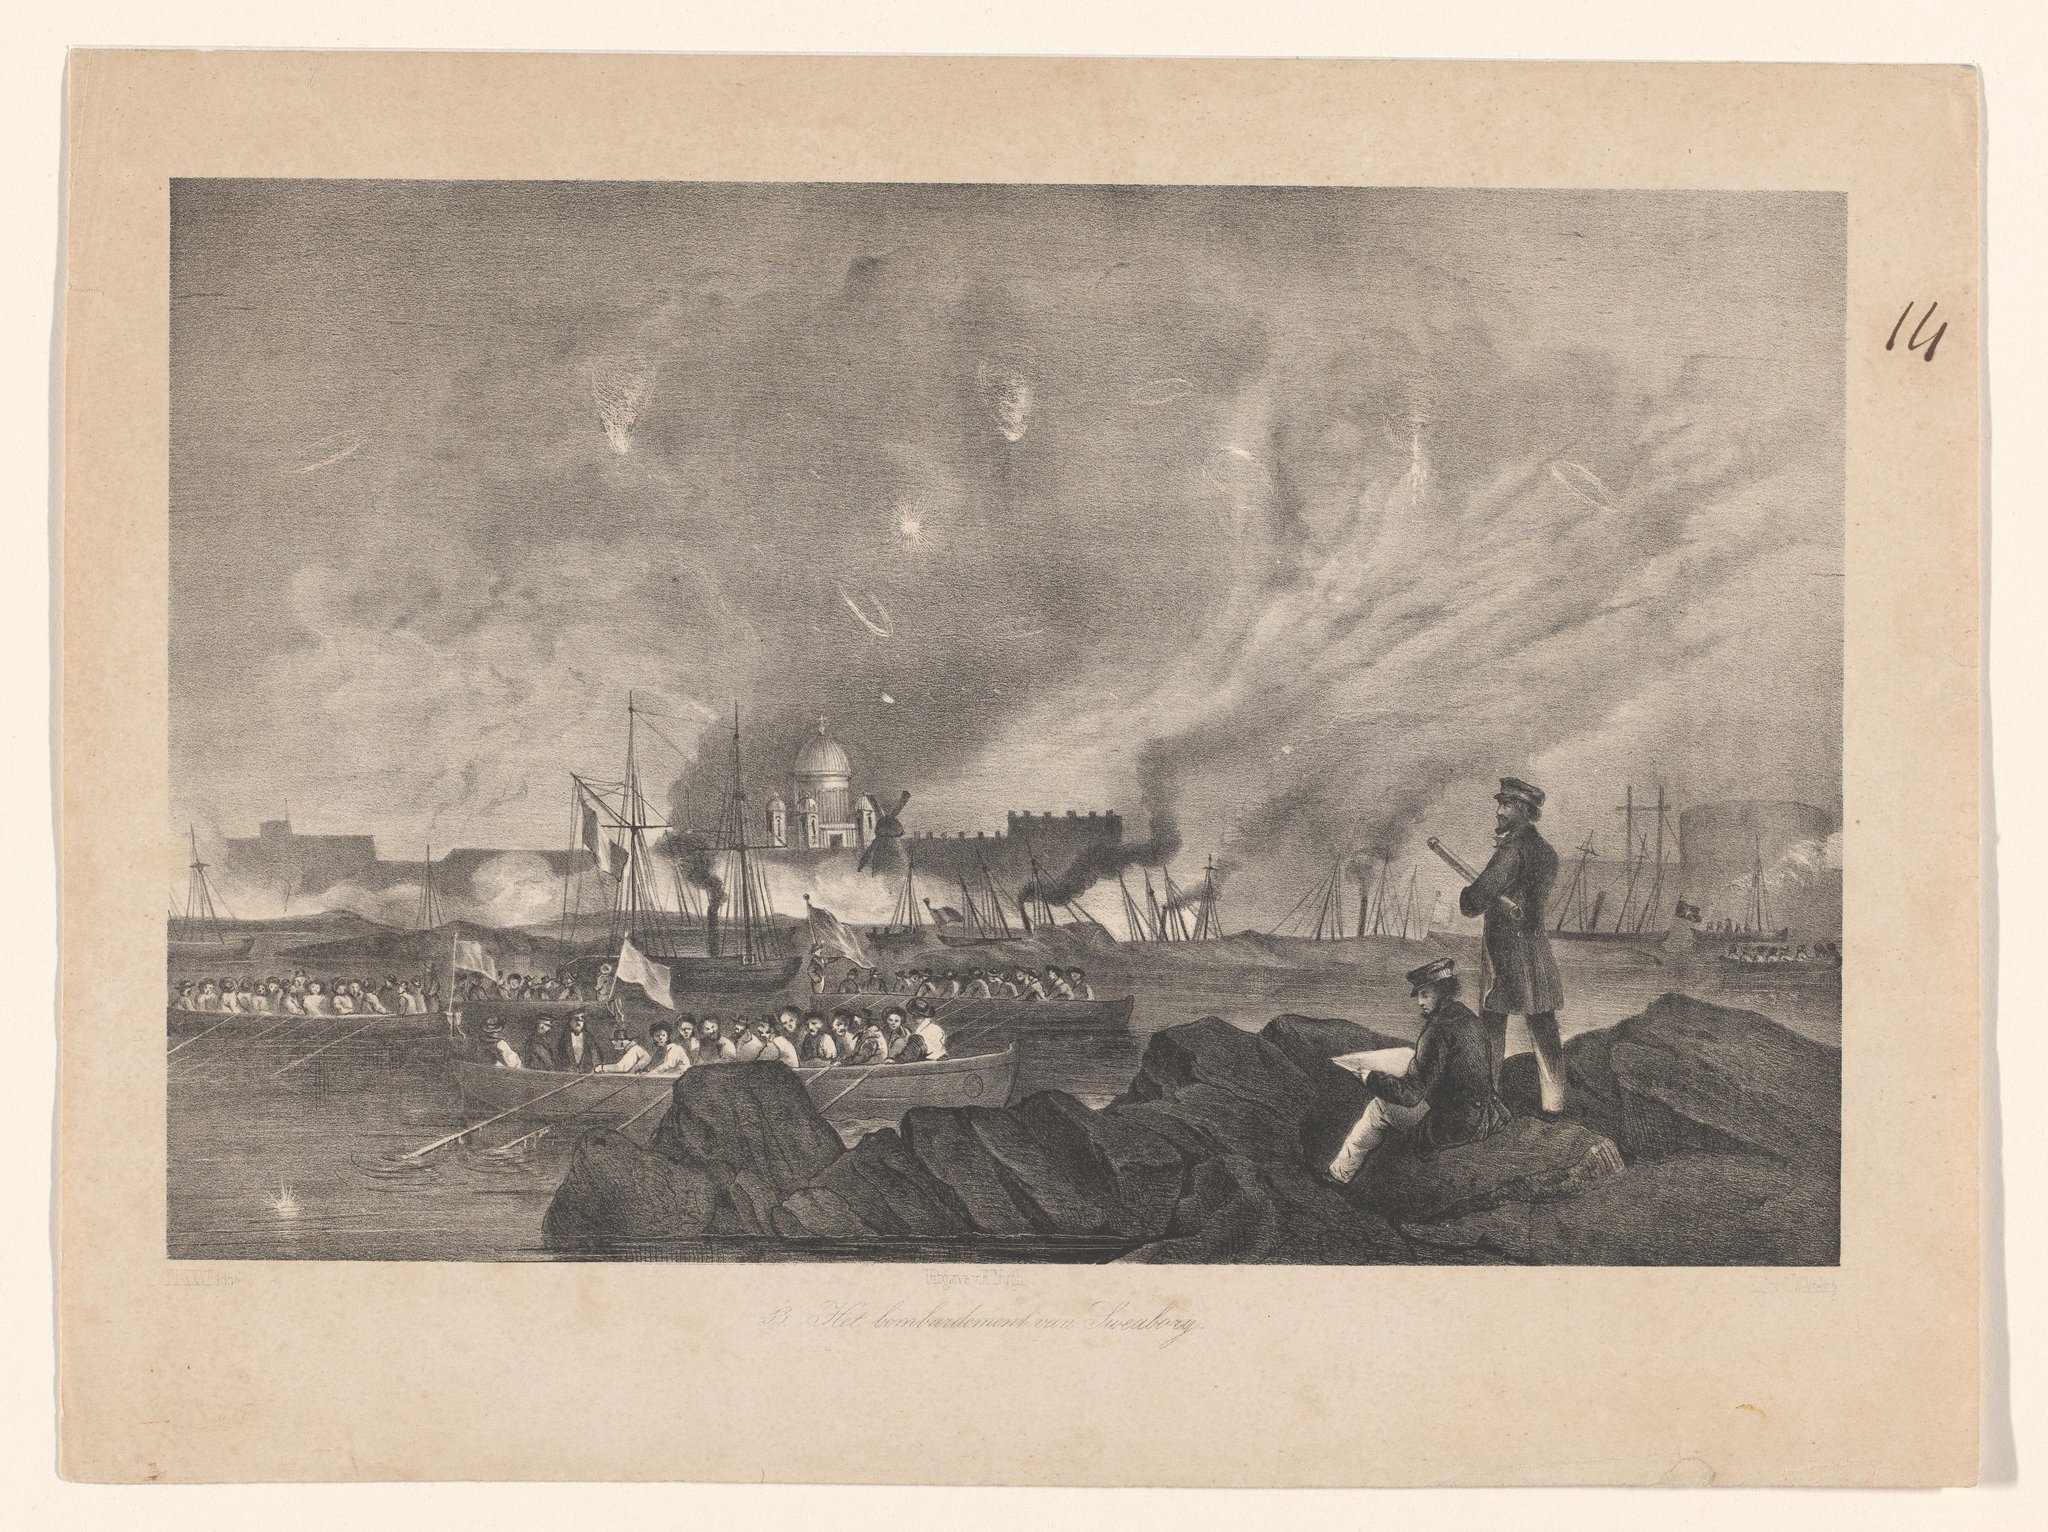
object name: print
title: Portret van Aleksej Jermolov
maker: Anonymous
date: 1855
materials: paper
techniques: letterpress printing, engraving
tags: politician, commander-in-chief, general, marshal, historical persons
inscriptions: signature: ‘Worm’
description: Prent uit: L'illustration: journal universel. Parijs: Dubouchet, 1855, dl. 23, p. 4.